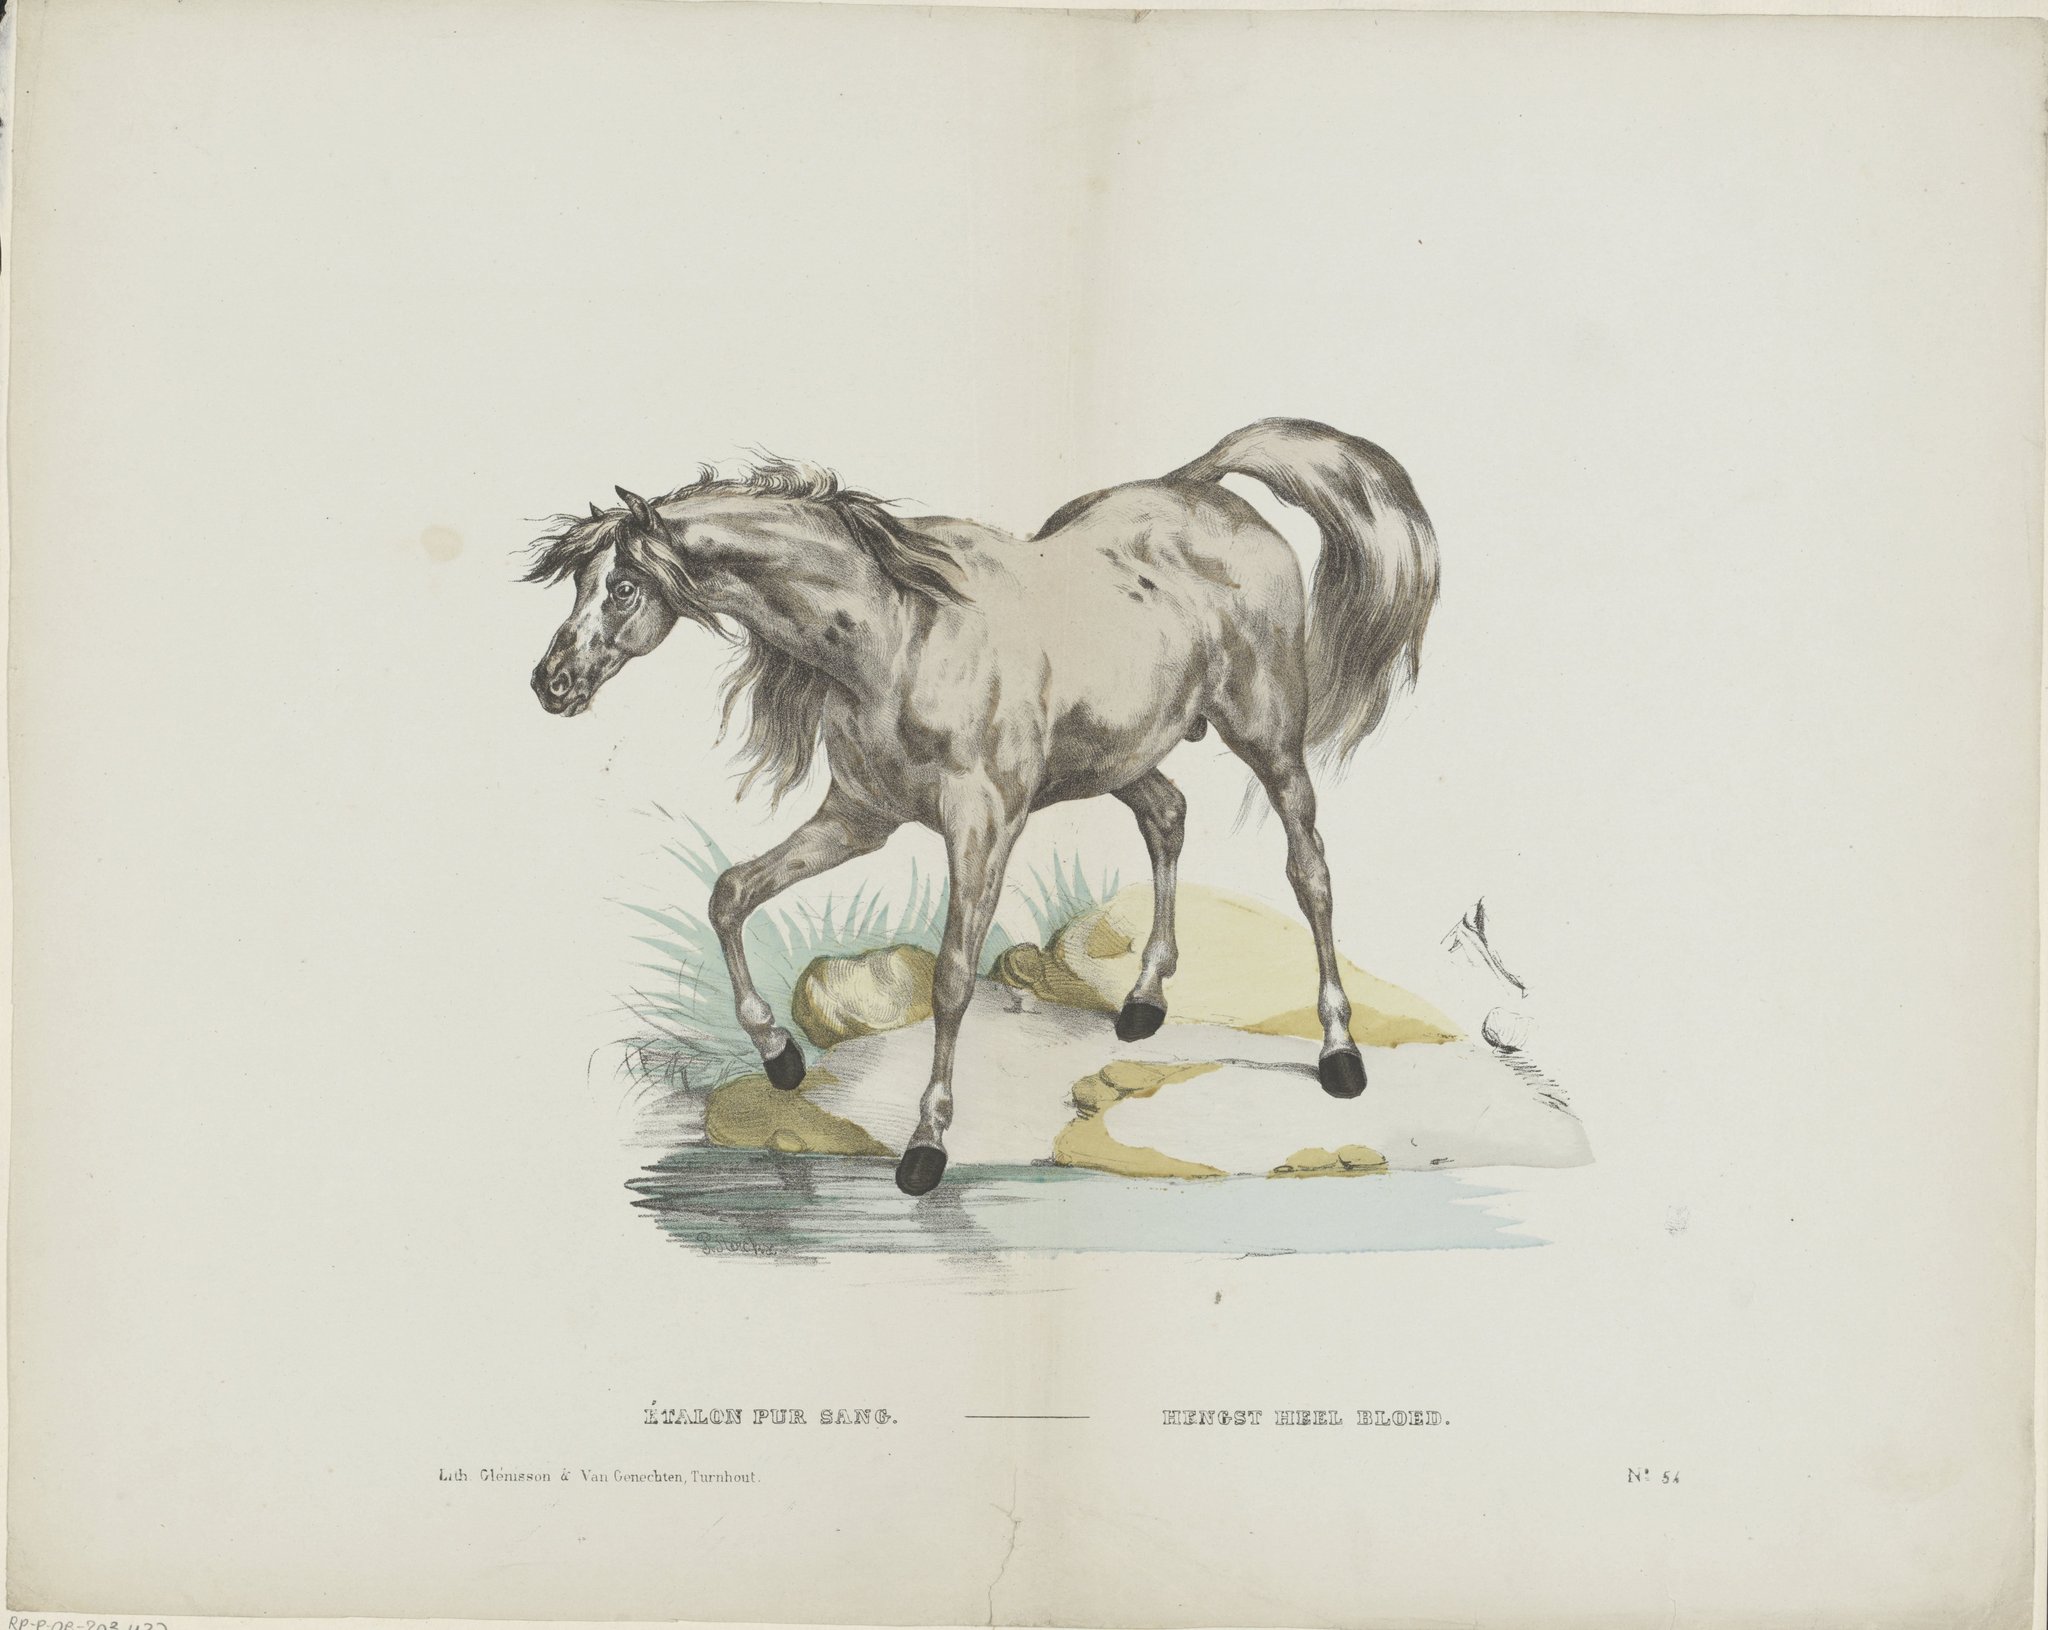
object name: print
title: Étalon pur sang / Hengst heel bloed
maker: Anonymous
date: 1833-1856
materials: paper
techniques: colour, letterpress printing, lithograph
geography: turnhout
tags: horse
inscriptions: collector's mark: Lugt 2760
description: Blad met een grote voorstelling van een hengst aan de waterkant. Onder de voorstelling de titel. Genummerd rechtsonder: No. 54.